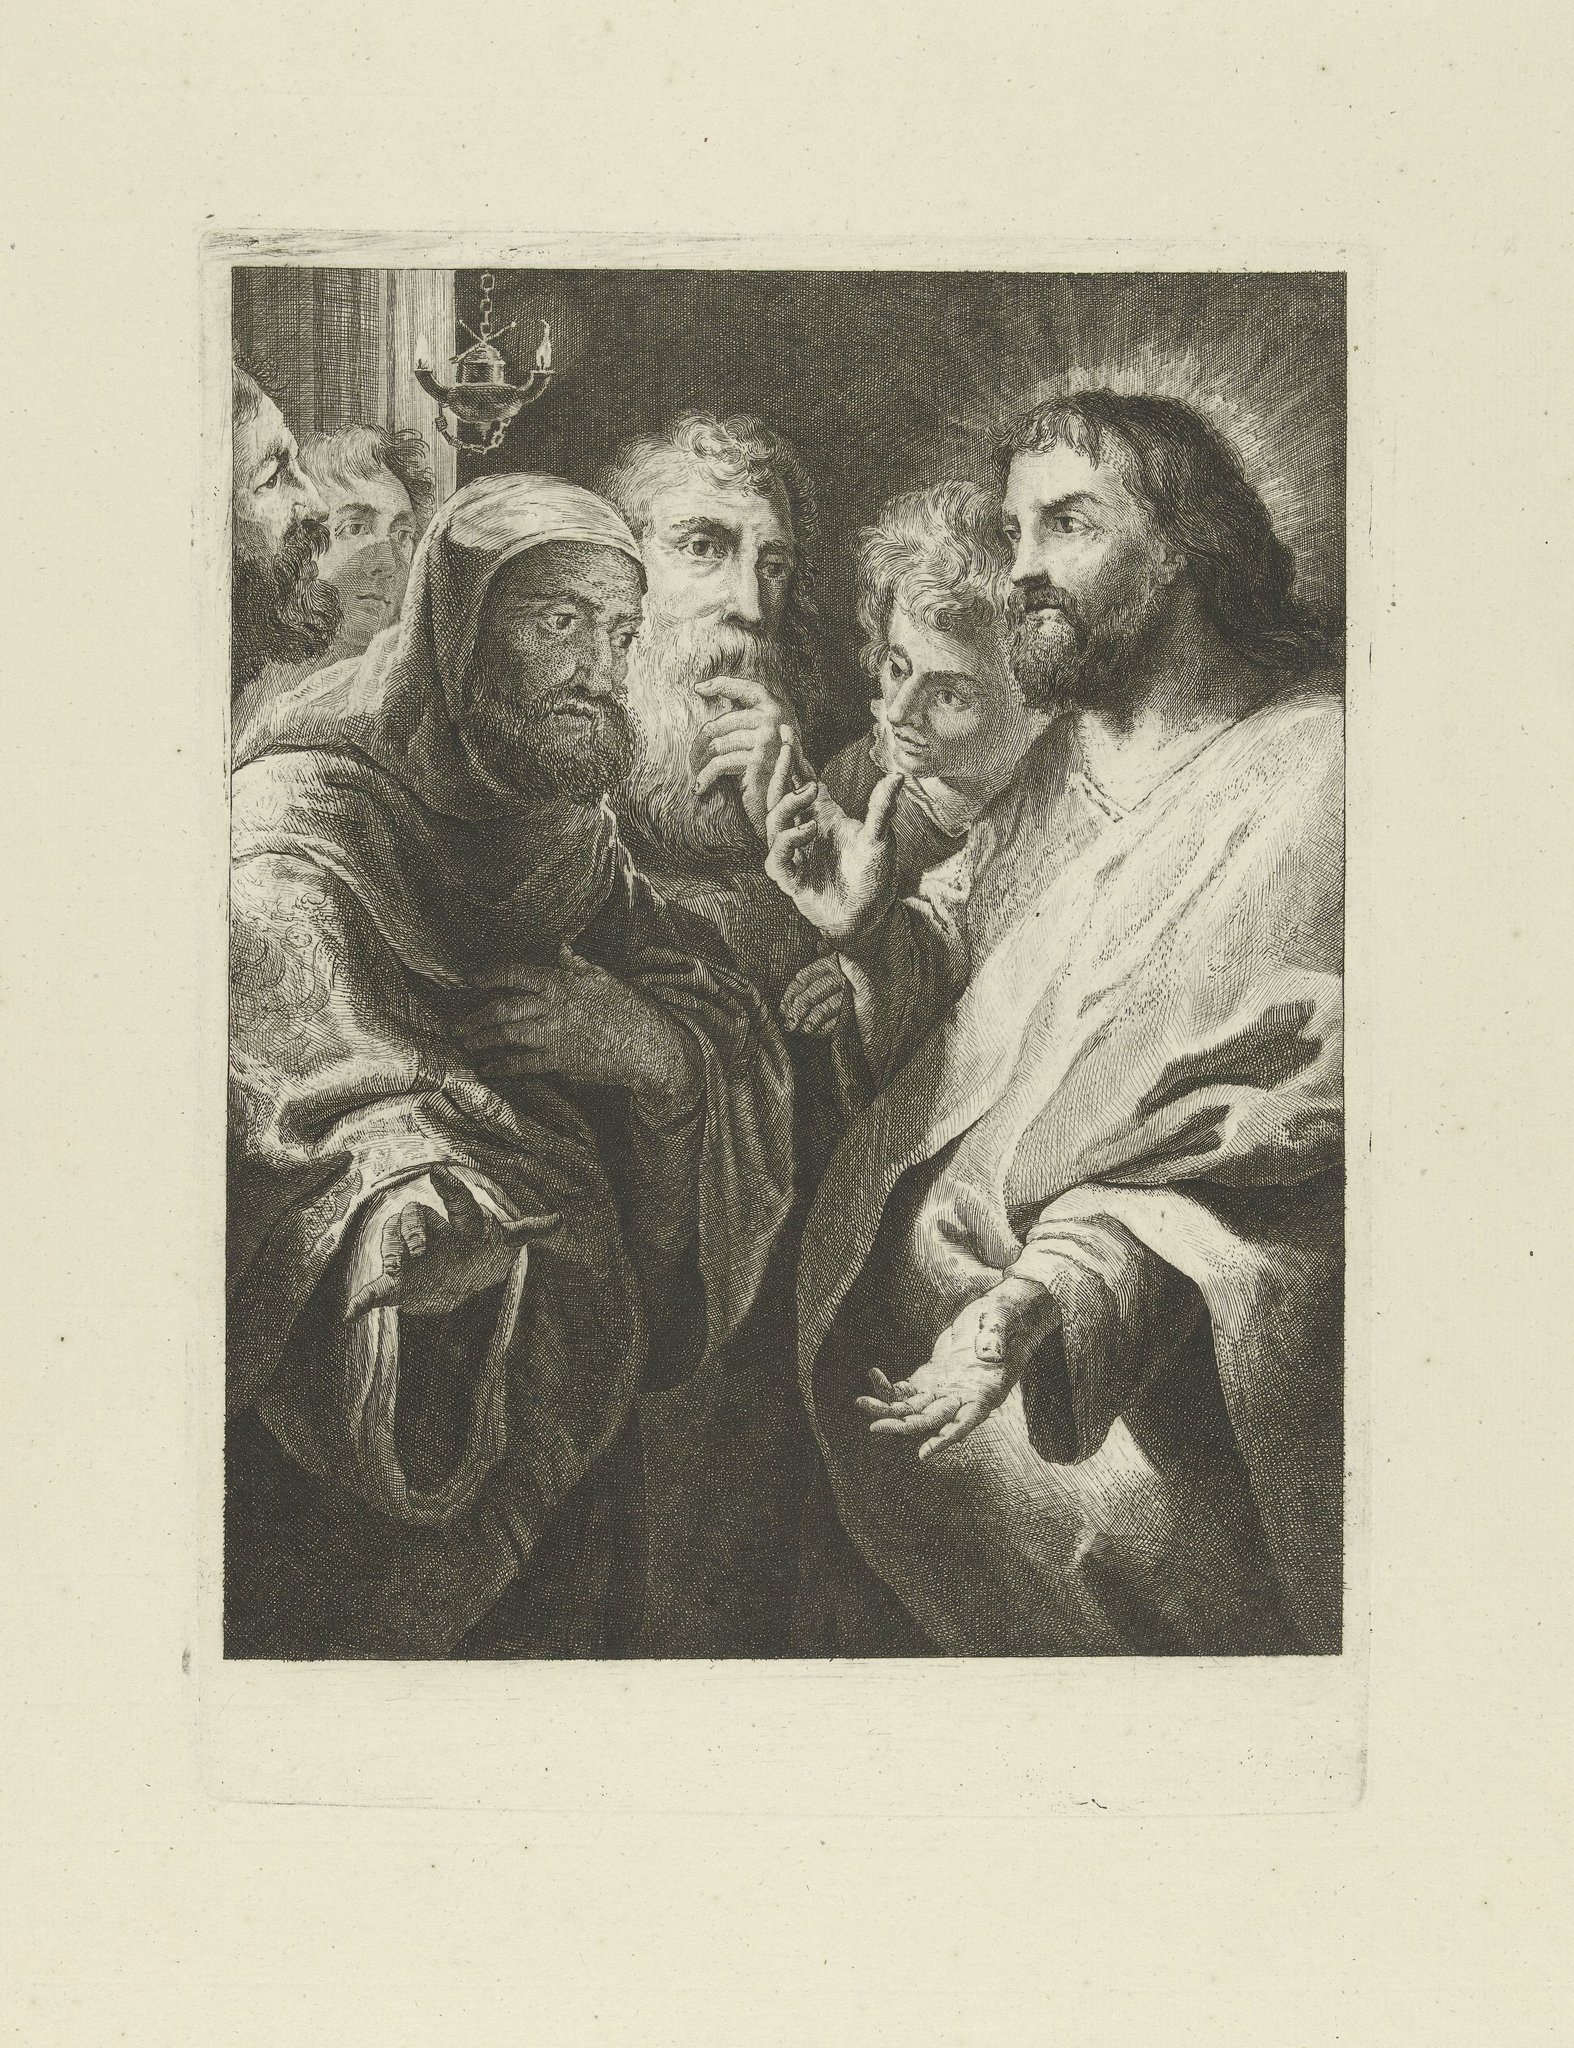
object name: print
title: Christus en Nicodemus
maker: jan lauwryn krafft (i)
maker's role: print maker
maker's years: 1694-1785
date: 1704-1765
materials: paper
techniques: engraving, etching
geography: southern netherlands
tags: christ talking with nicodemus at night (john 3:1-21)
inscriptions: collector's mark: Lugt 240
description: Christus in gesprek met Nicodemus, bij kaarslicht. Achter hen vier figuren.